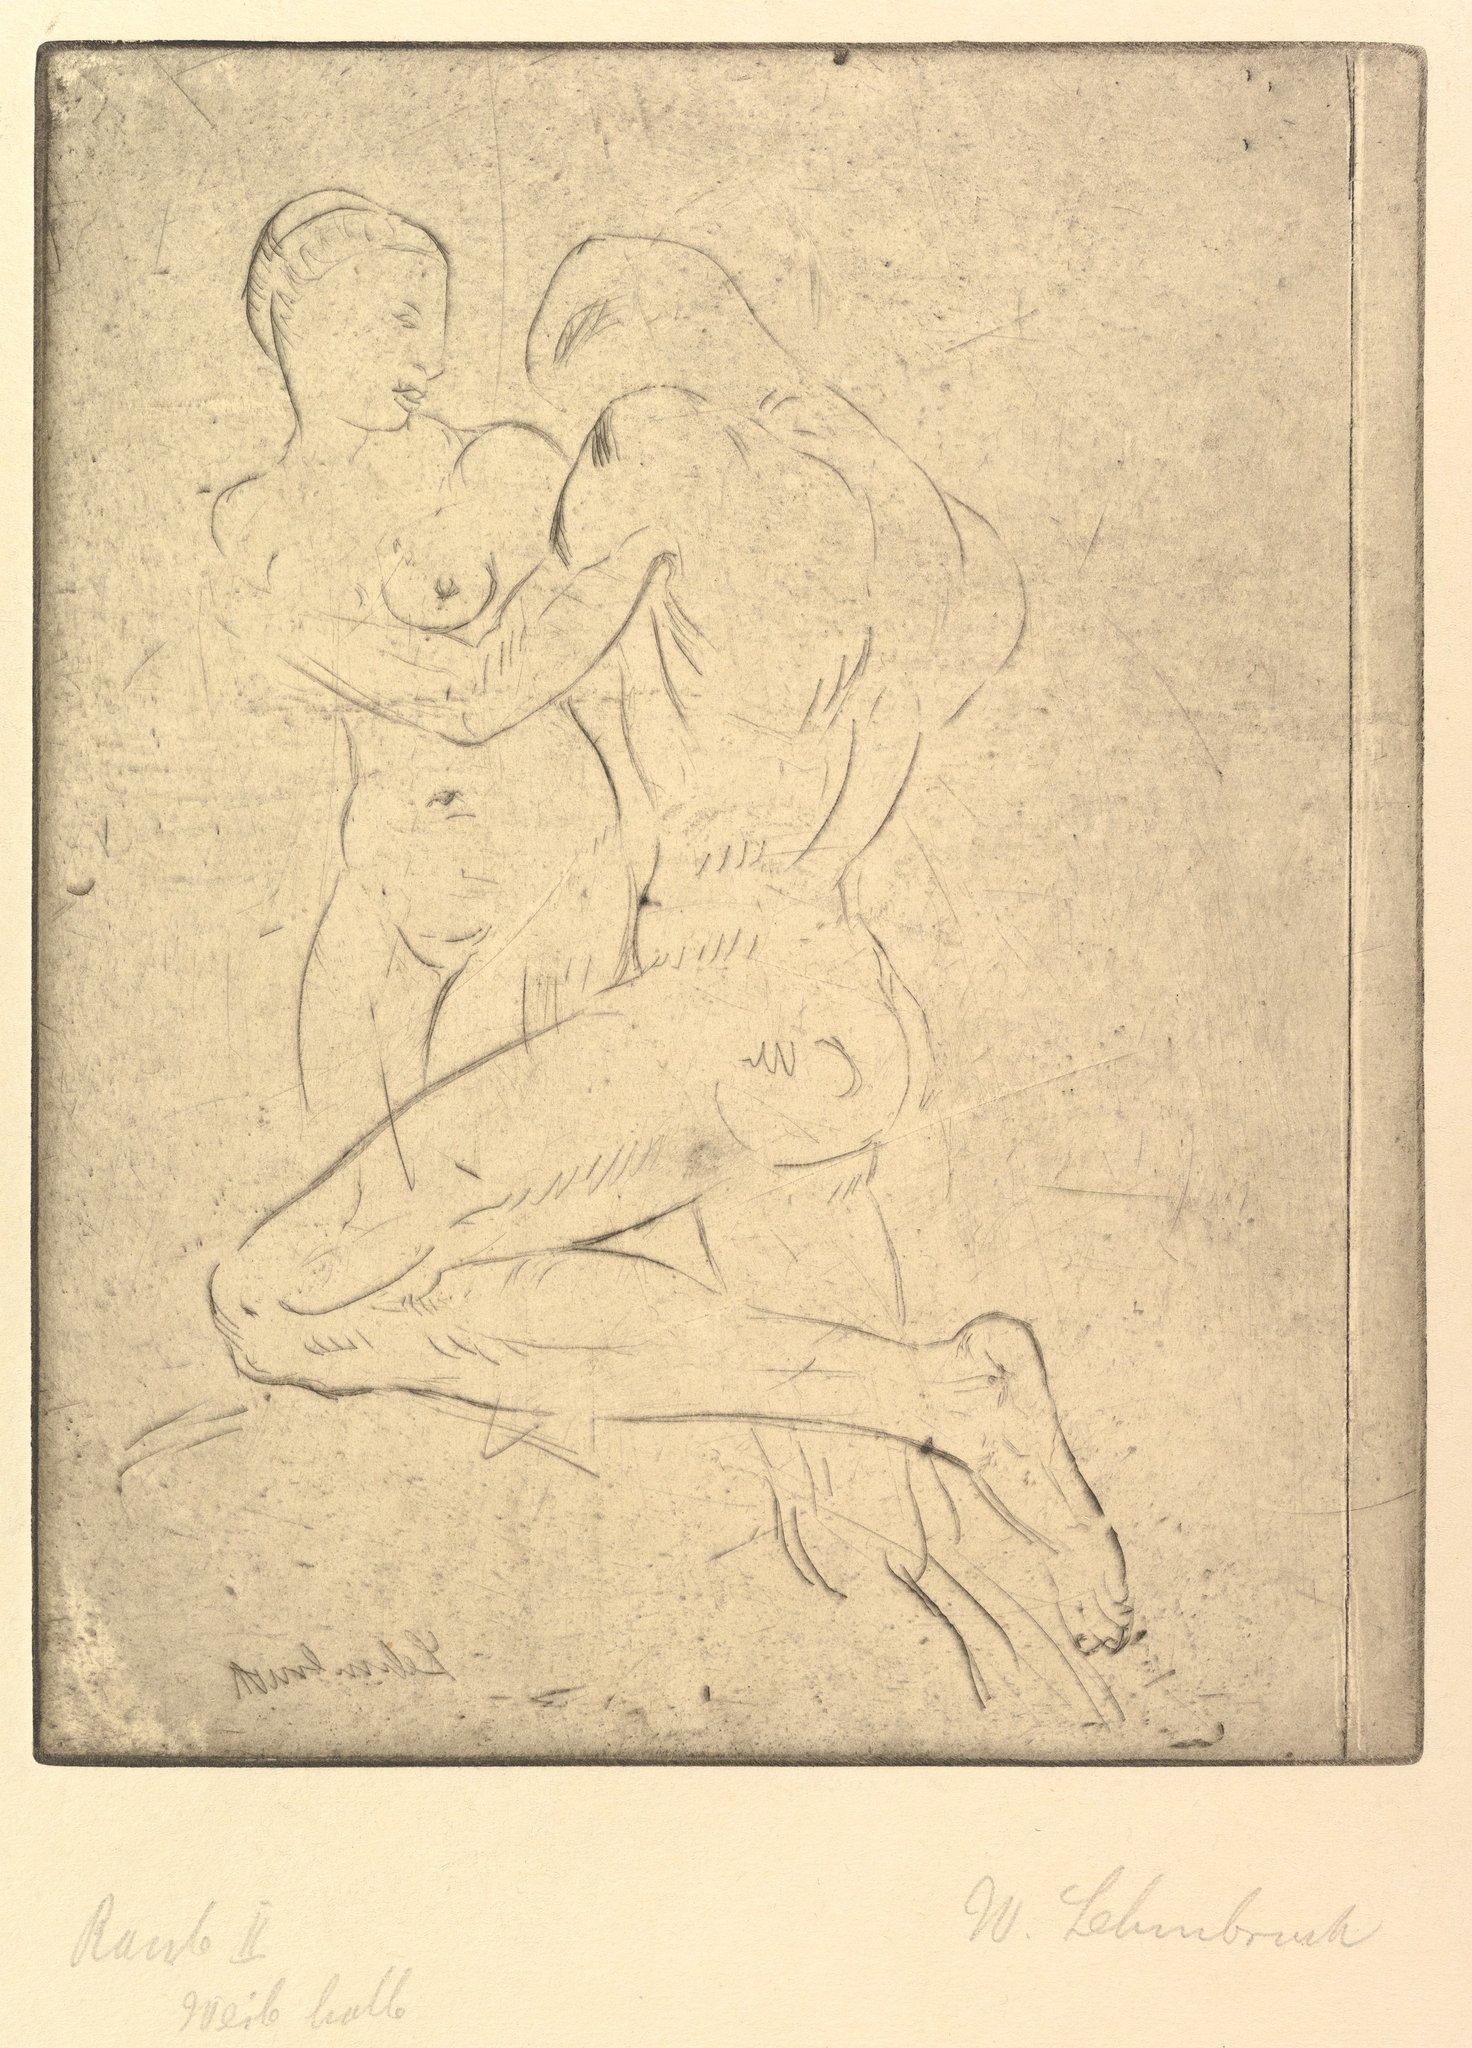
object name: print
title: Rape II (Raub II, Weib halb)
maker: wilhelm lehmbruck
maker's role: artist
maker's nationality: german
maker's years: 1881-1919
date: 1911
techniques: drypoint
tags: male nudes,female nudes